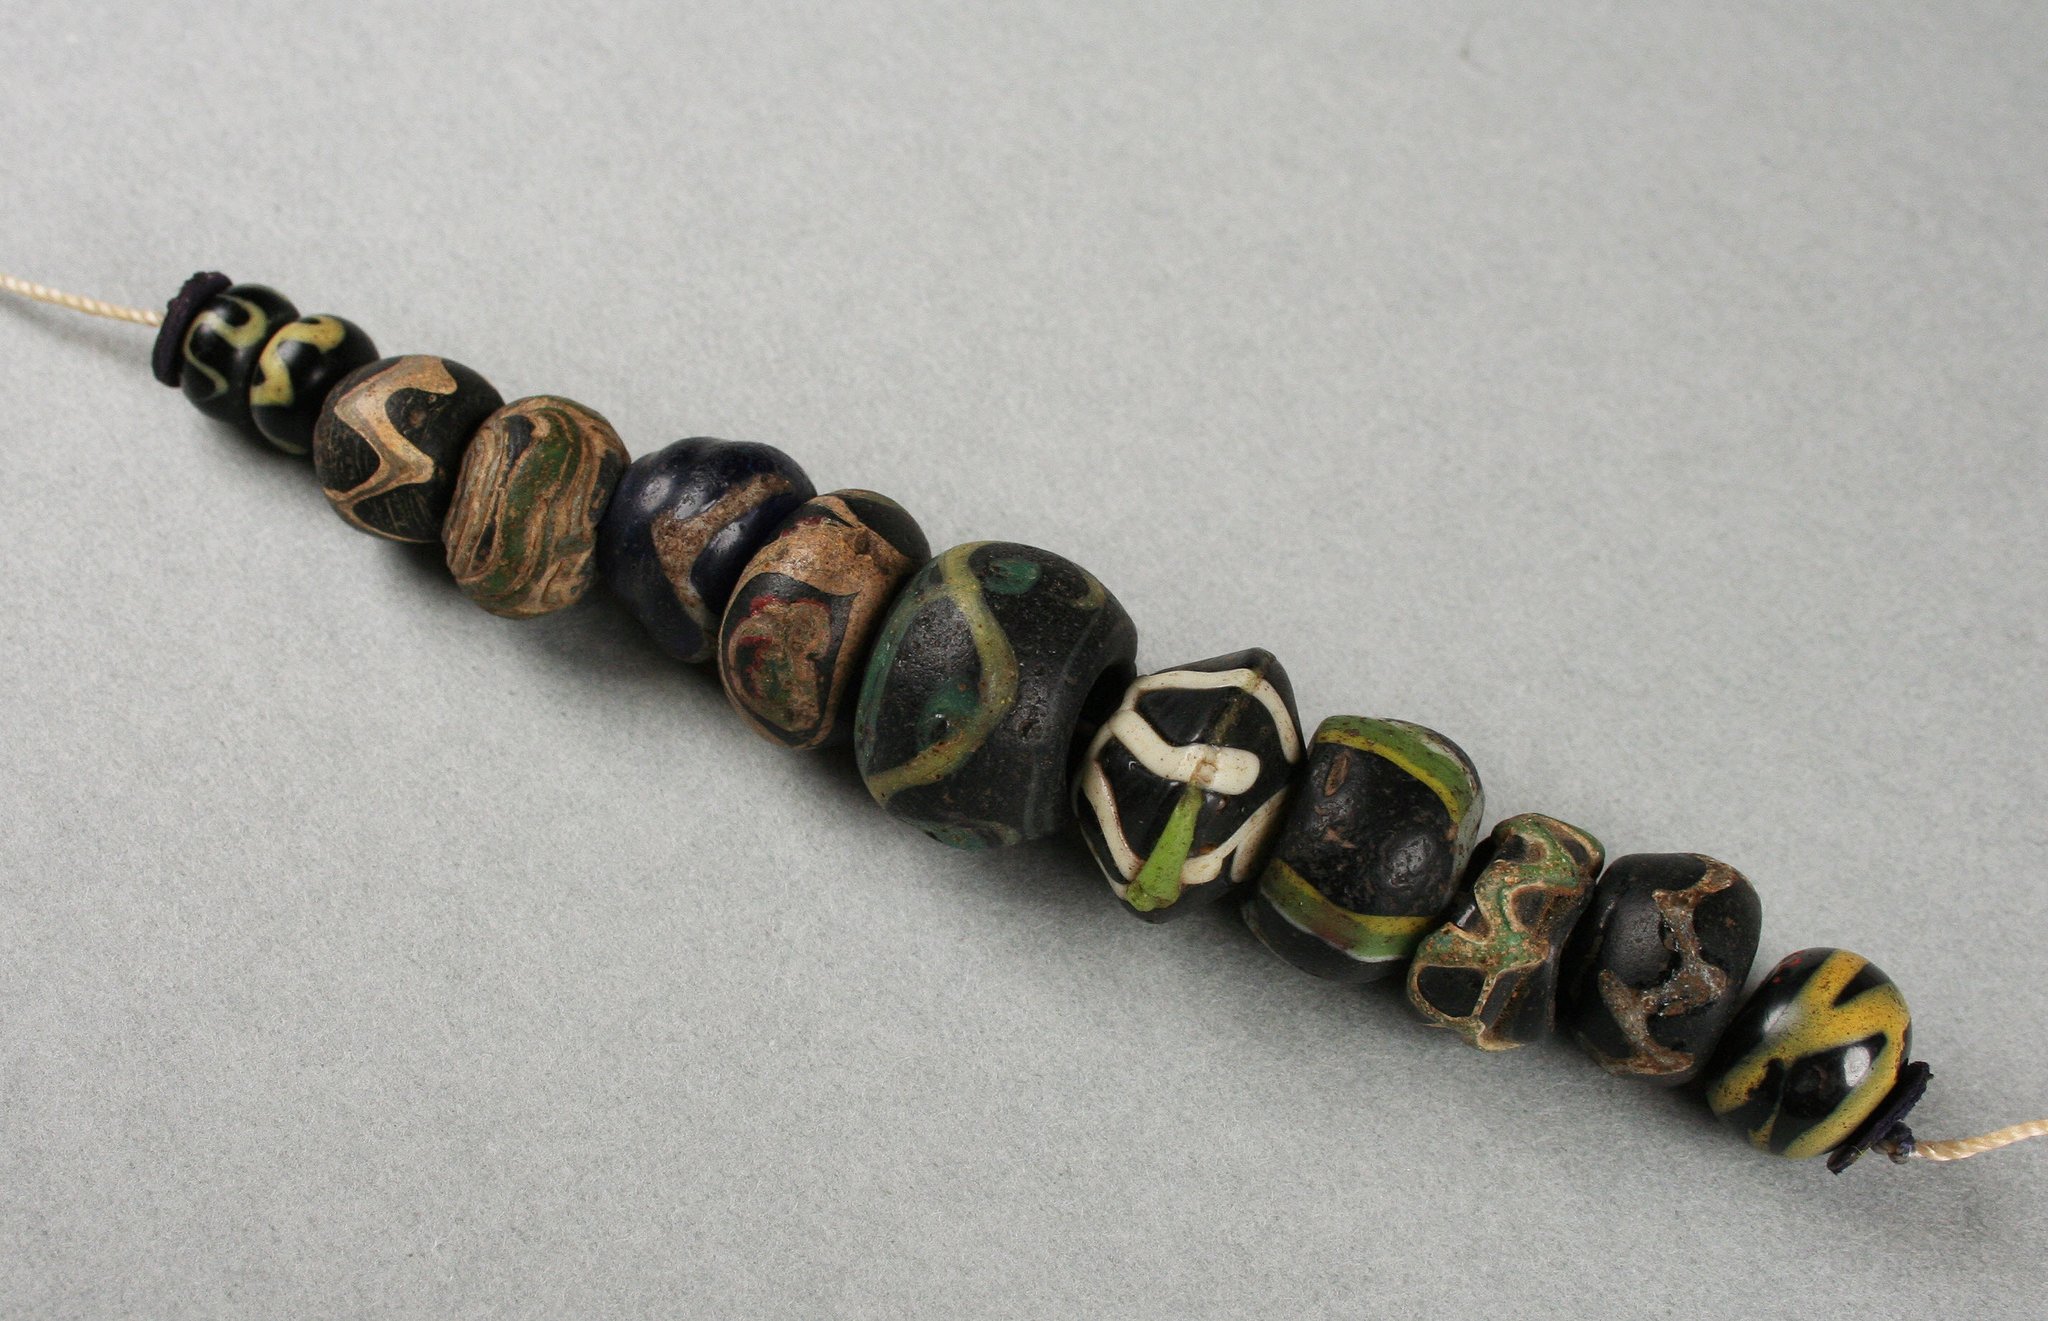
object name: bead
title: Beads, string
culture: african or european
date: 1701-1800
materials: glass